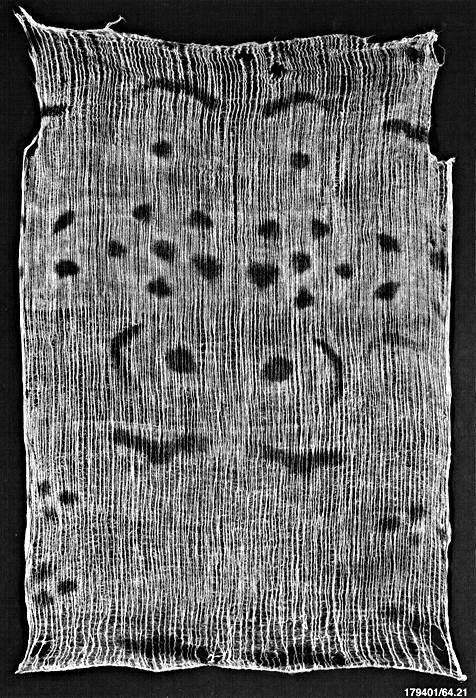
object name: thangka curtain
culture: chinese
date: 1601-1800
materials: silk